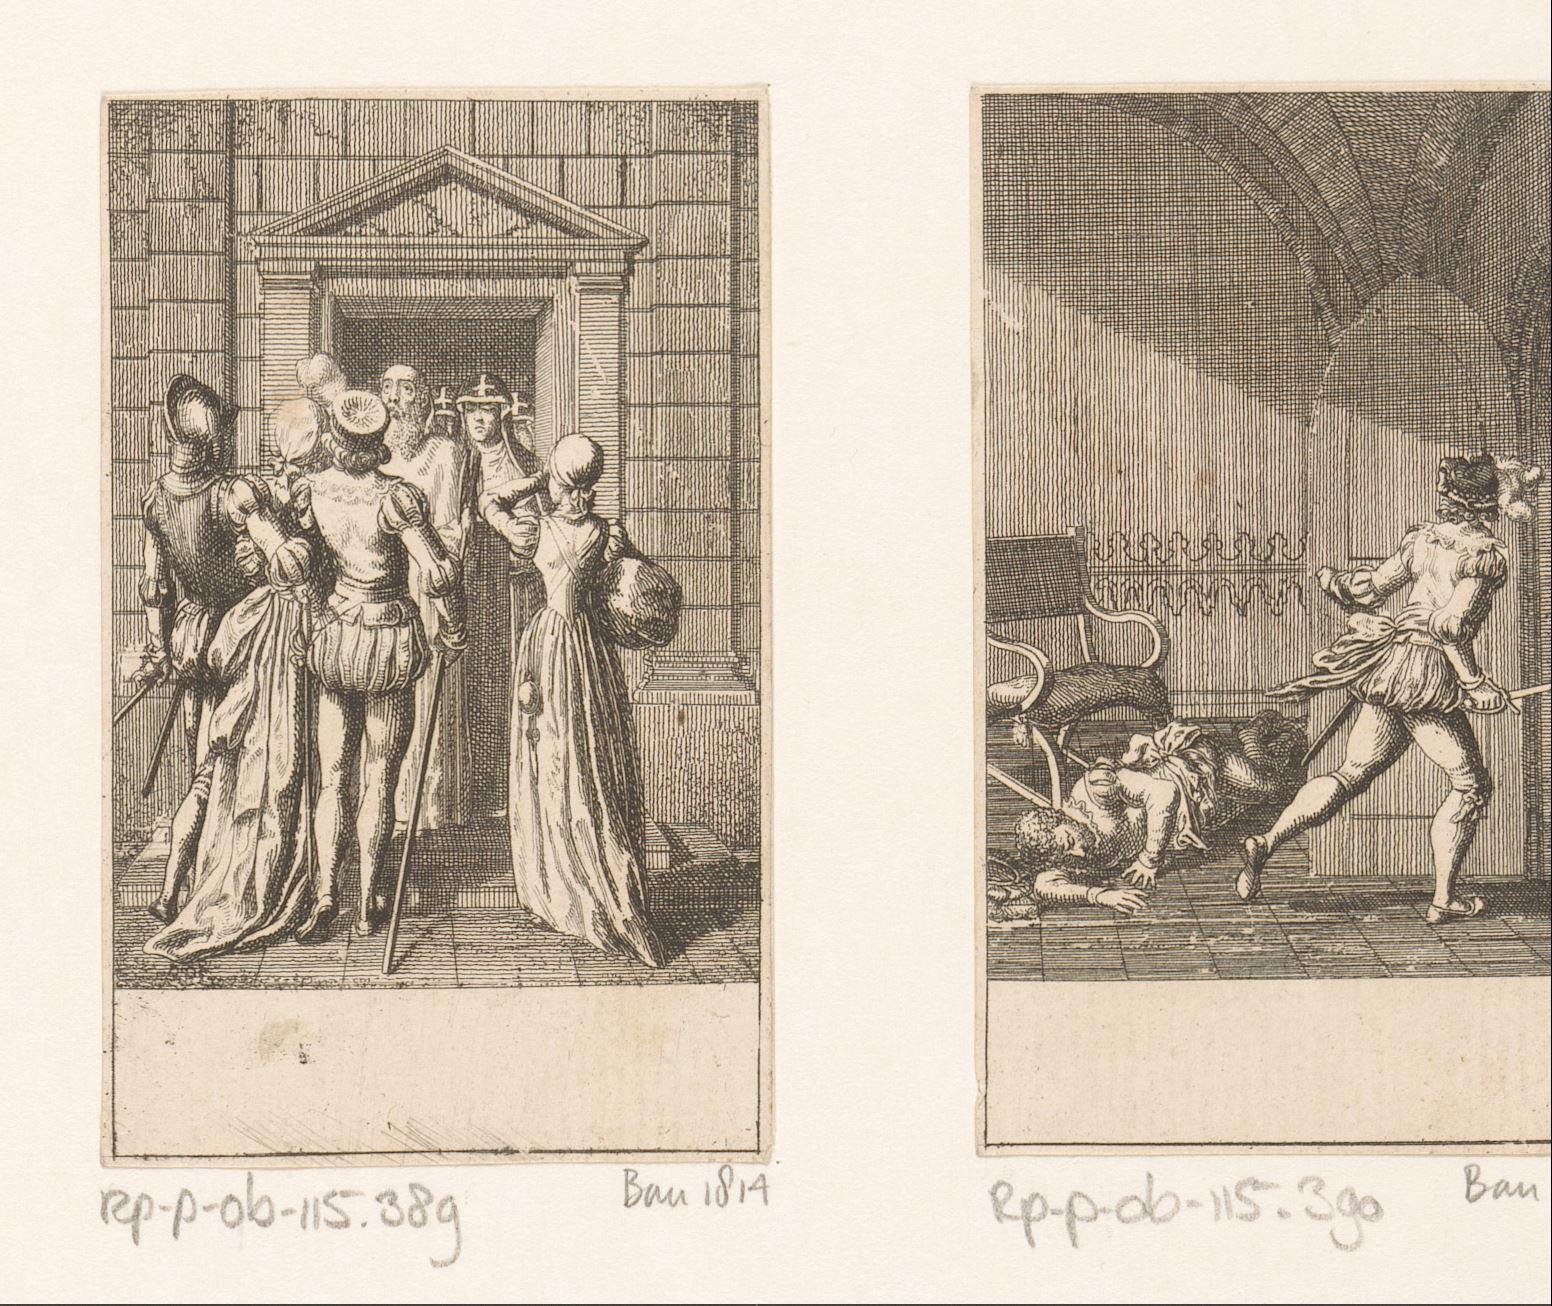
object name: print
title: Judith wordt opgenomen bij het klooster in Tours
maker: daniel nikolaus chodowiecki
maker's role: draughtsman, print maker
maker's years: 1726-1801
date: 1795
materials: paper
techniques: etching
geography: berlin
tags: france, history, nun(s), cloisters ~ monastery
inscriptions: collector's mark: Lugt 2228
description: Latere staat gebruikt voor: Königl. Grossbritanischer Historischer Genealogischer Calender für 1796 (...). Lauenburg en Franfurt am Main: Johann Georg Berenberg en Jaegerschen Buchhandlung, [1795].